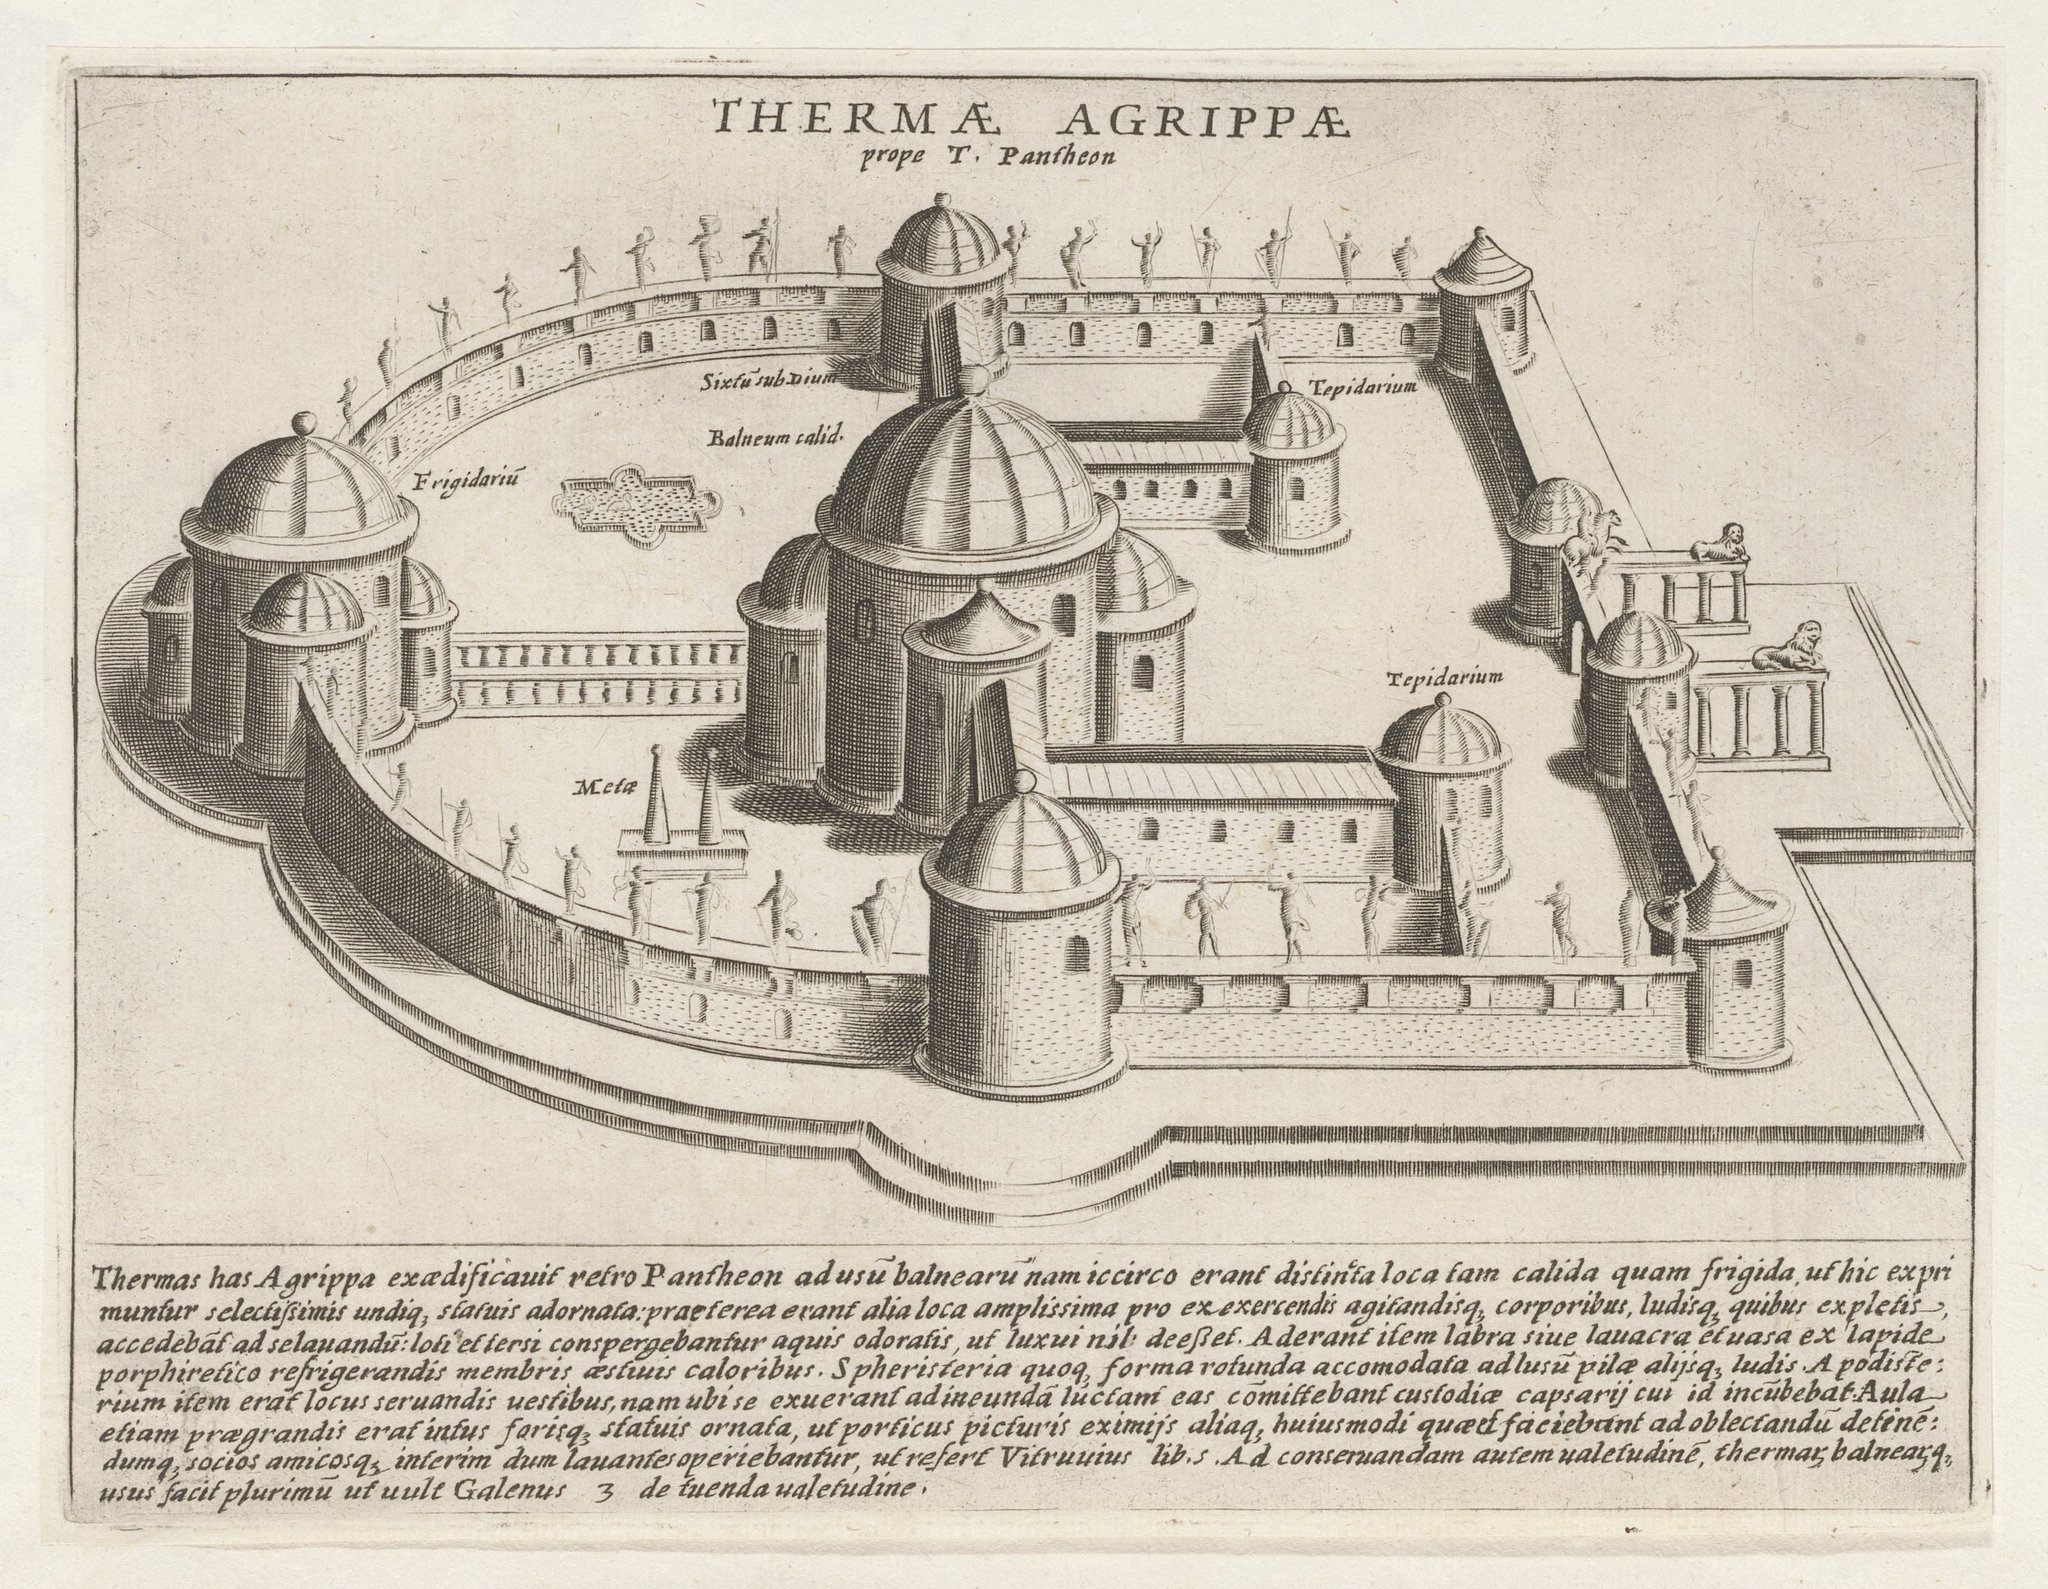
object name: album leaf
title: Thermae Agrippae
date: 1612-1628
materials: paper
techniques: etching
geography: rome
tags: public baths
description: Deze prent maakt deel uit van een set van 158 prenten (+ titelprenten), die verscheen in vier delen. In 1612 verschenen delen één en twee. In 1615 verscheen het derde deel en in 1628 verscheen deel vier. In 1637 publiceerde Vitale Mascardi de eerste heruitgave van de gehele set met nummering.